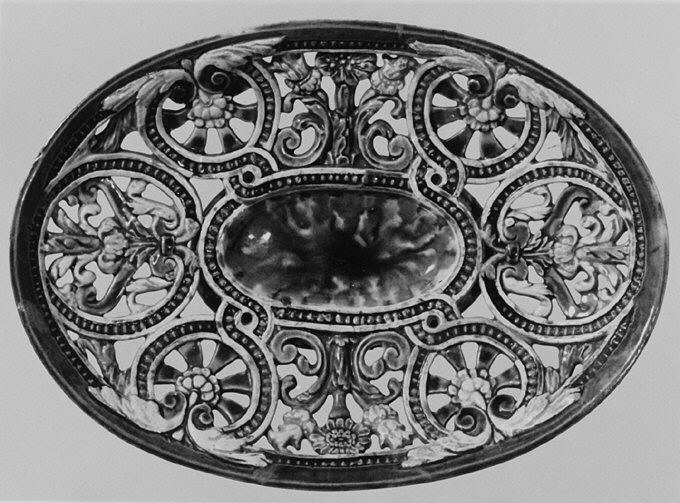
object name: dish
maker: bernard palissy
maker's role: maker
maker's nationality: french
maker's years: 1510-1590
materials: earthenware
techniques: glazing